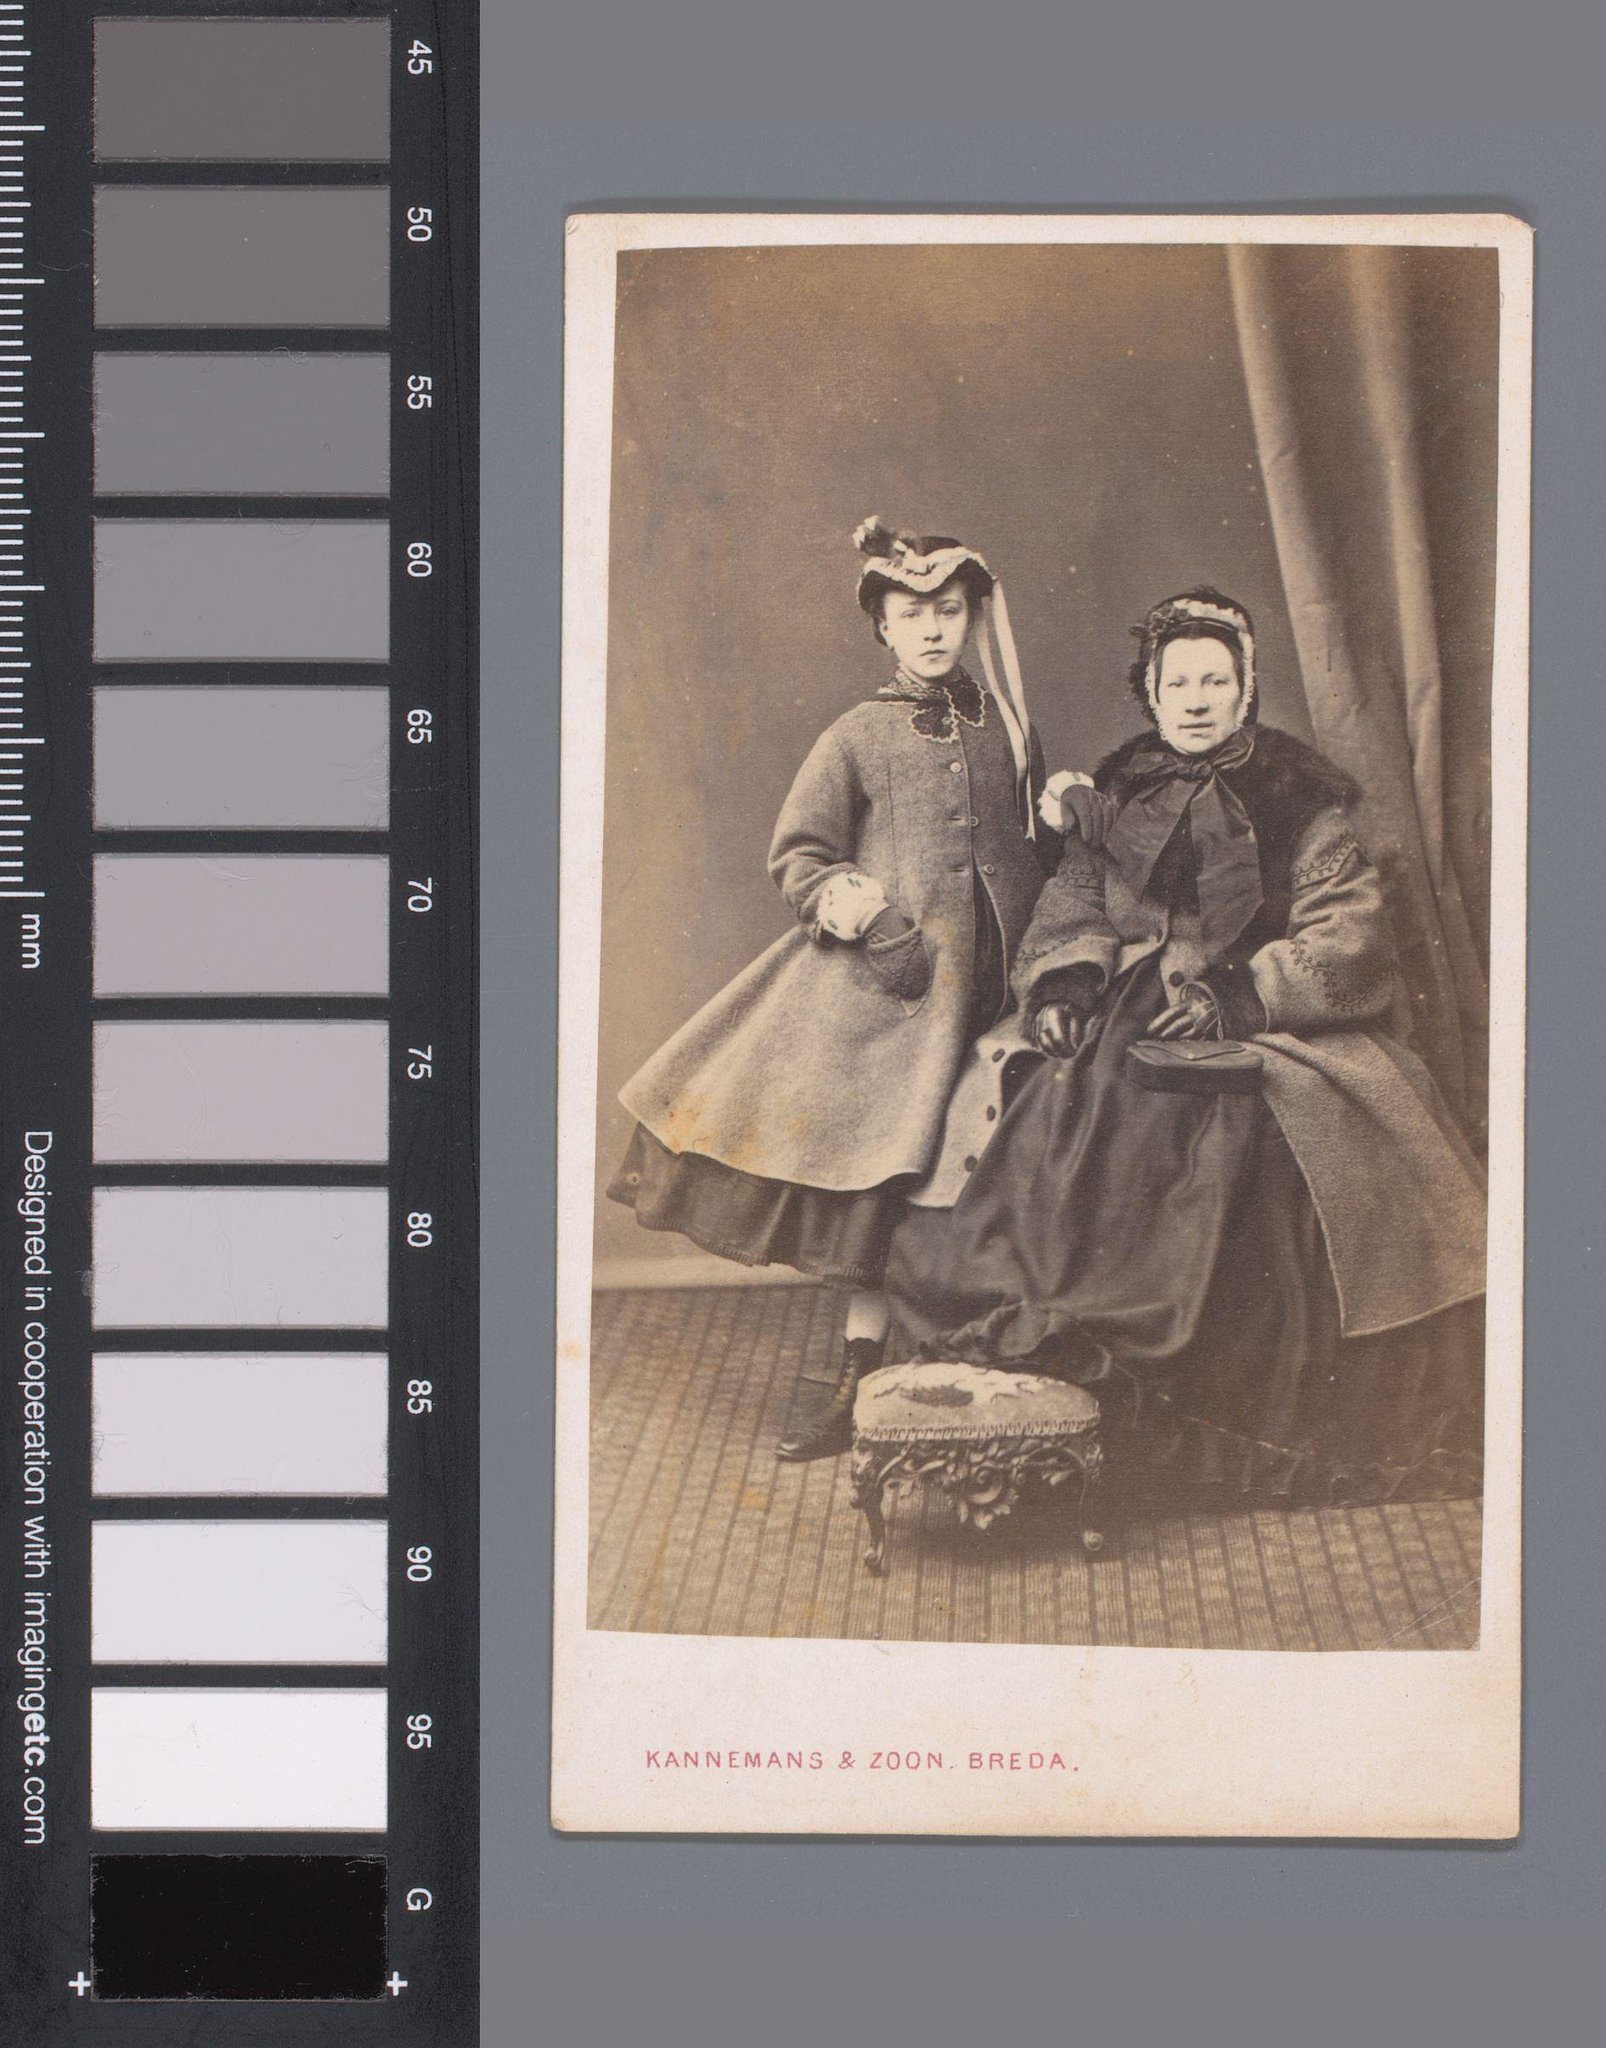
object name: carte de visite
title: Portret van een onbekende vrouw en een onbekend meisje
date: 1867-1879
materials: cardboard, paper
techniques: albumen print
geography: breda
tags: historical persons, mother and daughter(s) (family group)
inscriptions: inscription: ‘KANNEMANS EN ZOON/ Artiste Photographen/ VAN/ Z.M. DEN KONINGE N H.M. DE KONINGIN/ BREDA/ Groote Markt/ D. 15./ tegen over het Stadhuis/ 1856’